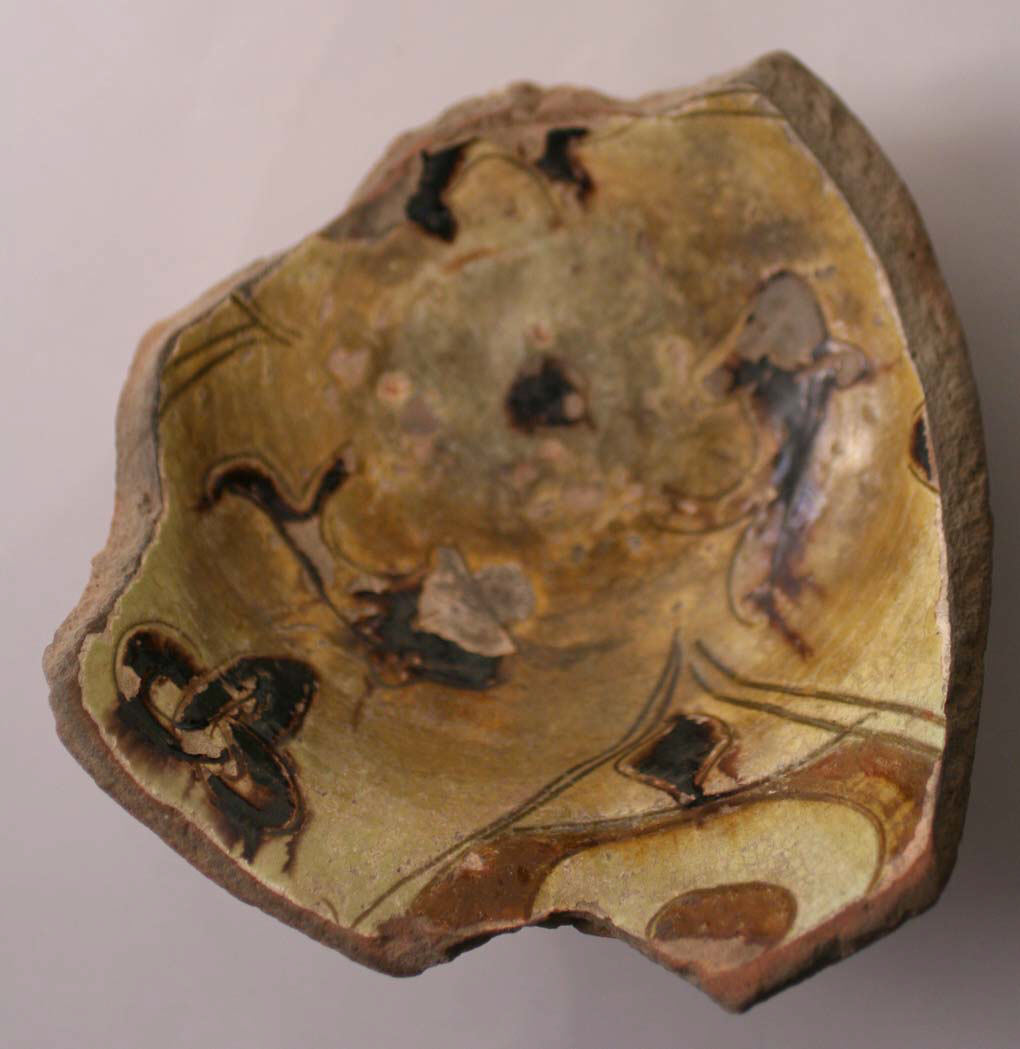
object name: ceramic fragment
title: Fragment of a Bowl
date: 1301-1500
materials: earthenware, glaze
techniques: coloring, incising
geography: egypt